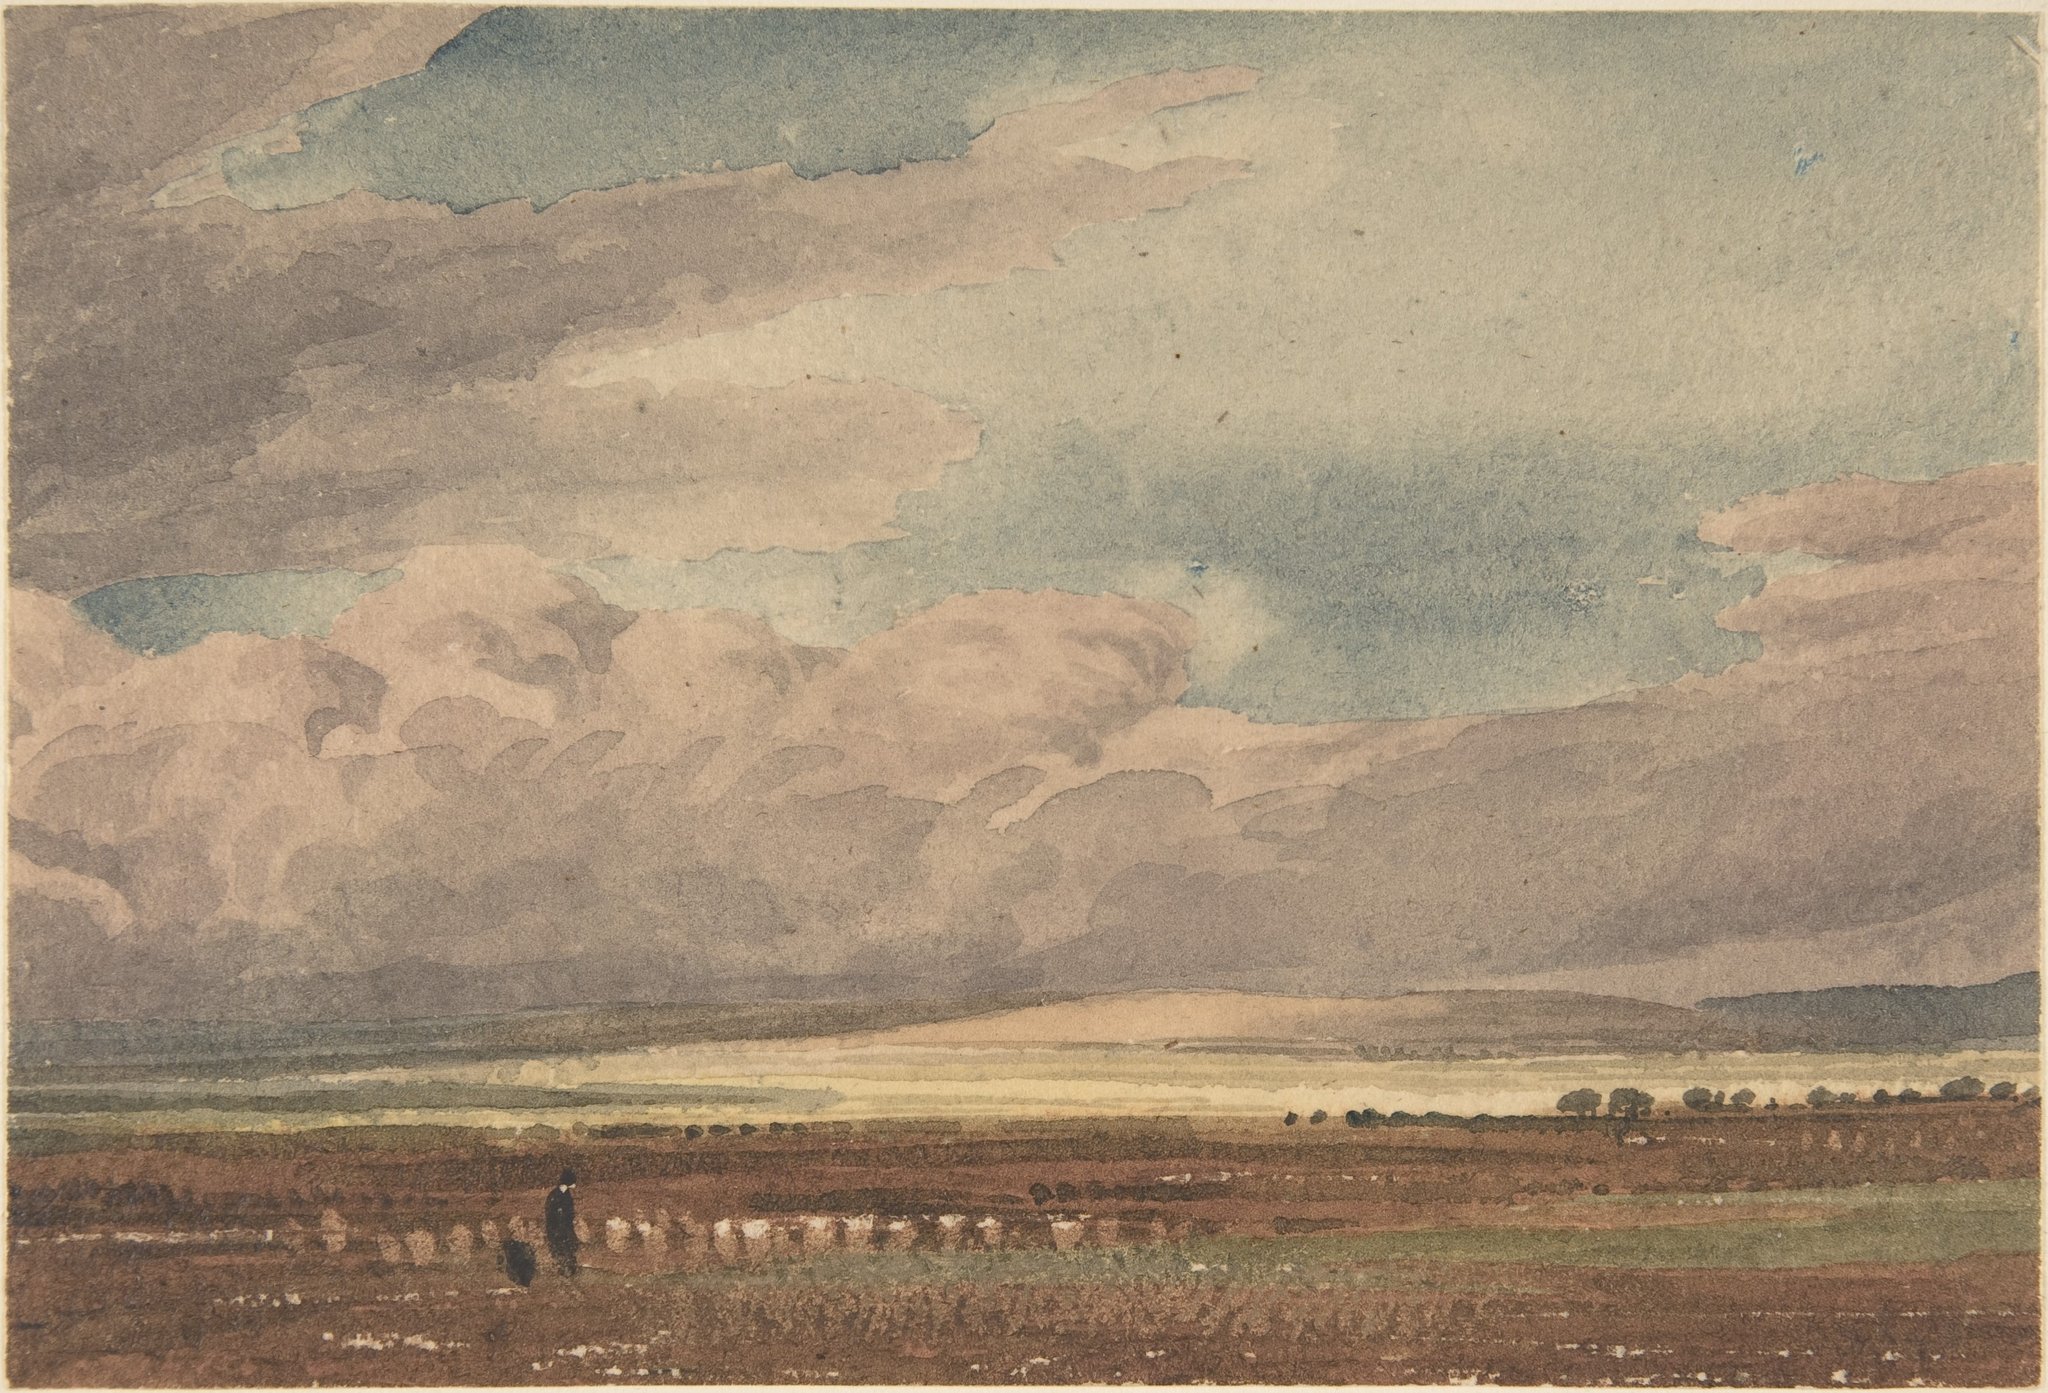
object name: drawing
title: Salisbury Plain with Old Sarum in the distance, Wiltshire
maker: william turner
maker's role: artist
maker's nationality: british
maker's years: 1789-1862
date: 1810-1862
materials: graphite, gum arabic, watercolor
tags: landscapes